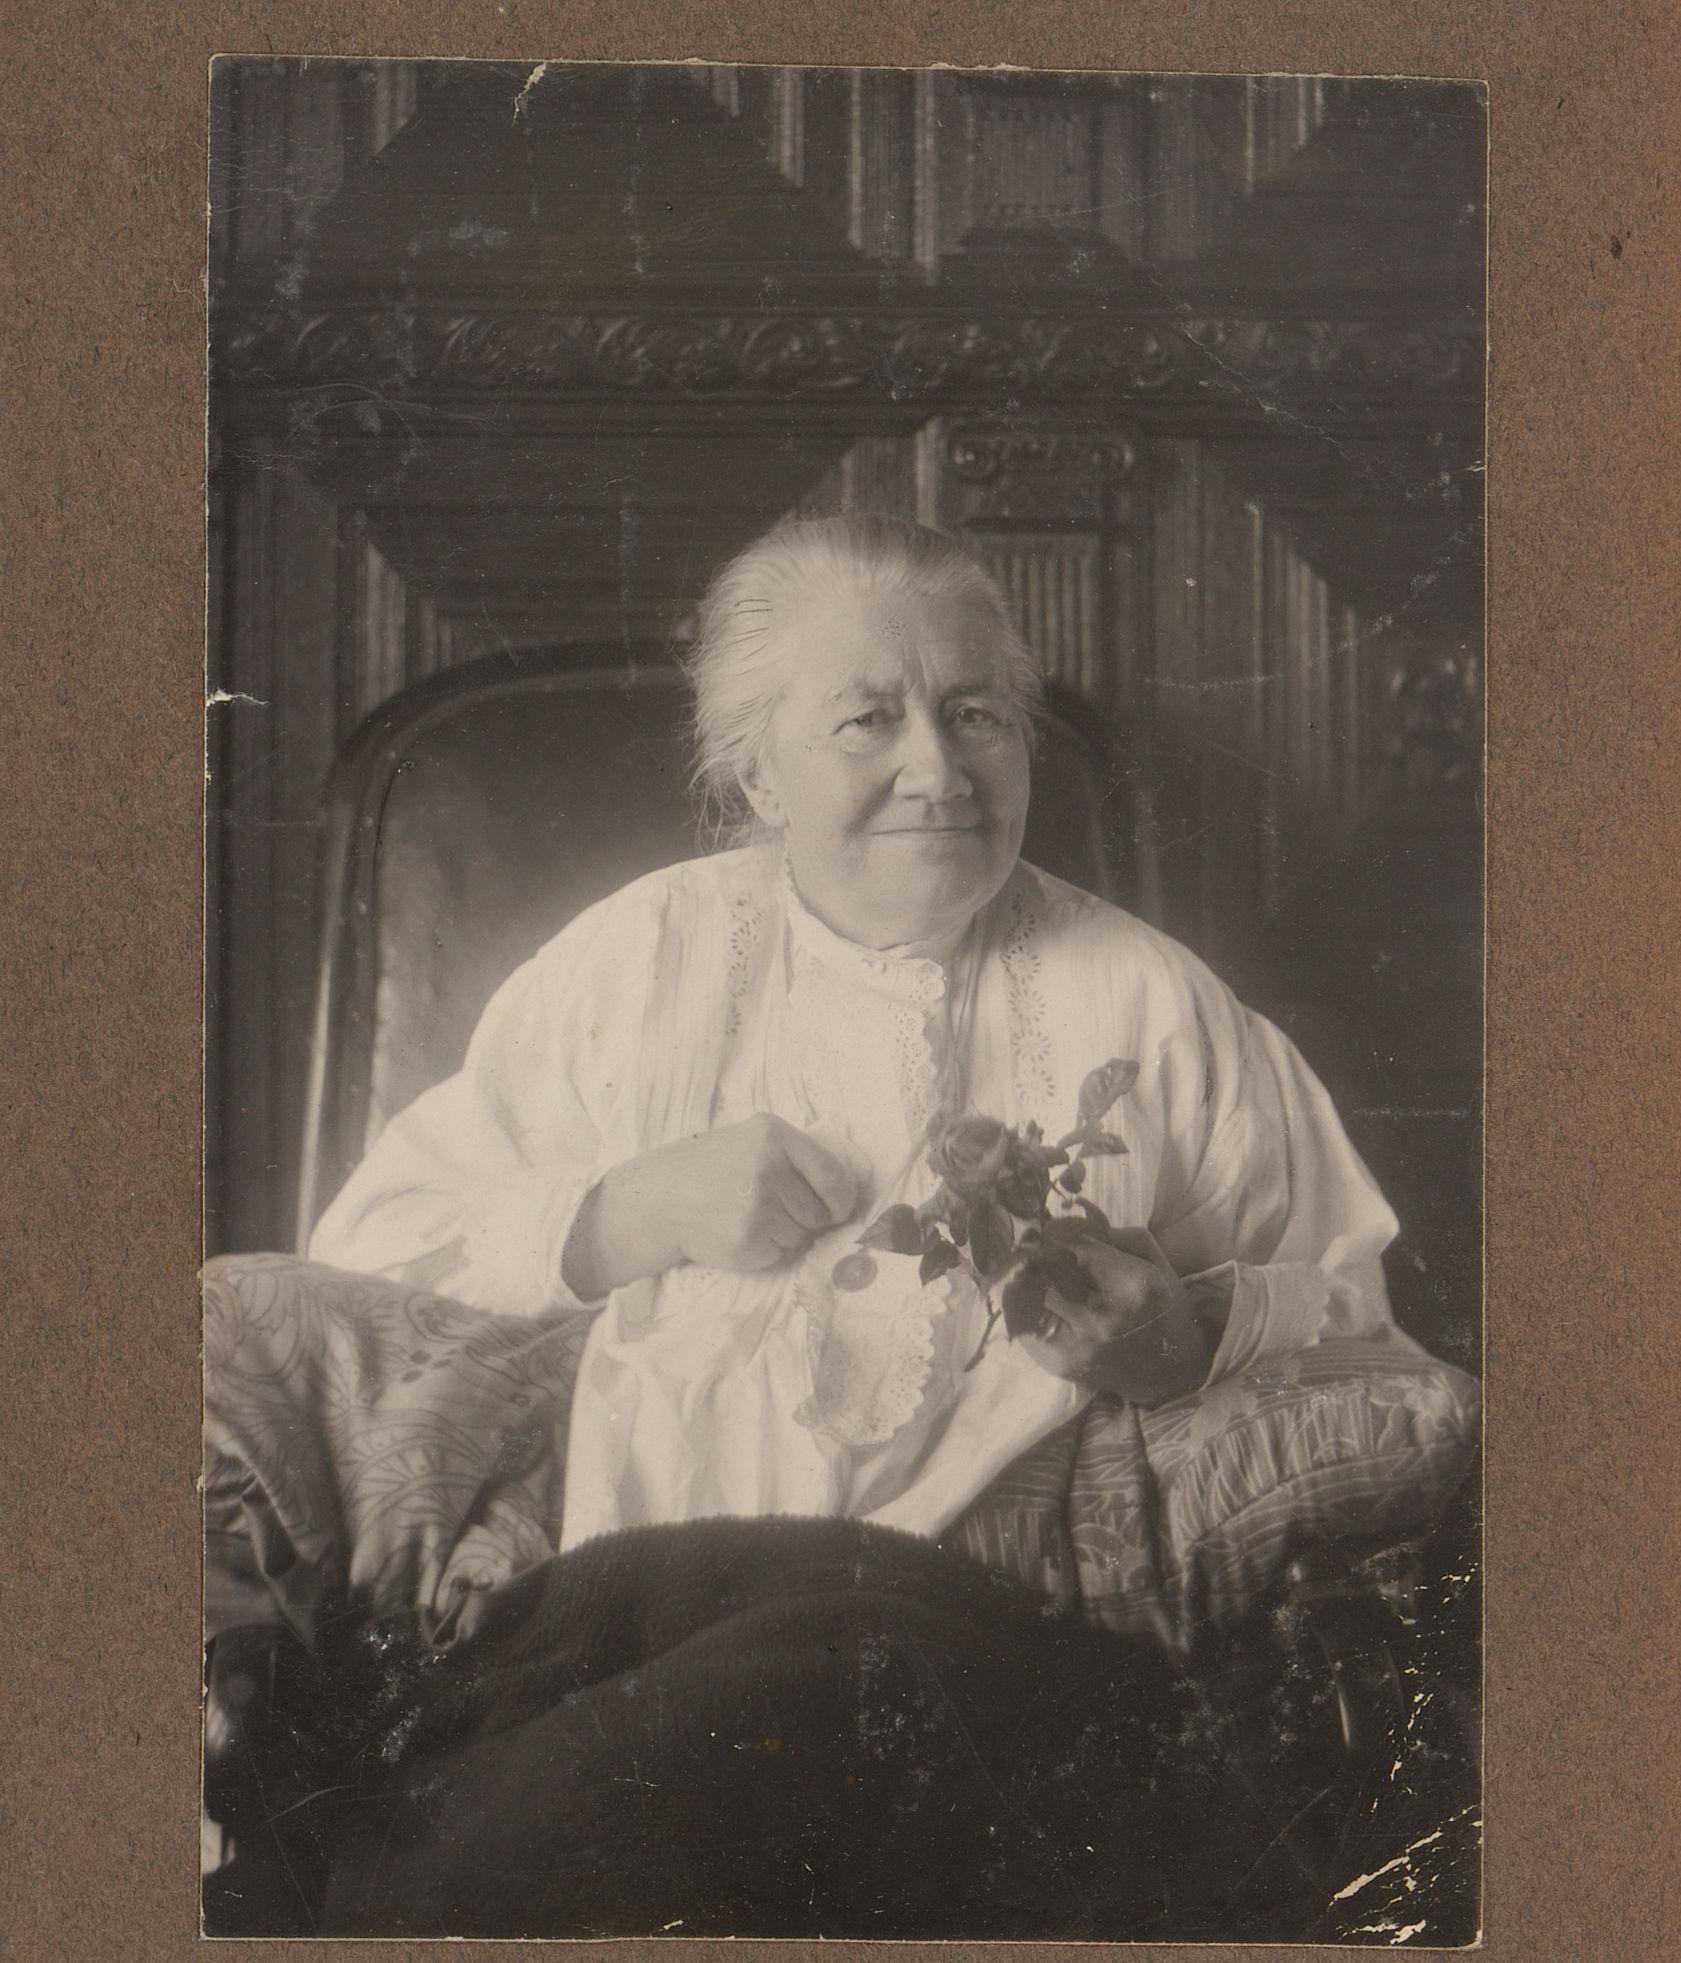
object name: photograph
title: Portret van vrouw in interieur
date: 1870-1920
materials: photographic support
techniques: photography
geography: netherlands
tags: netherlands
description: Foto op bruin albumblad 31 van familiealbum van Alphons Diepenbrock.